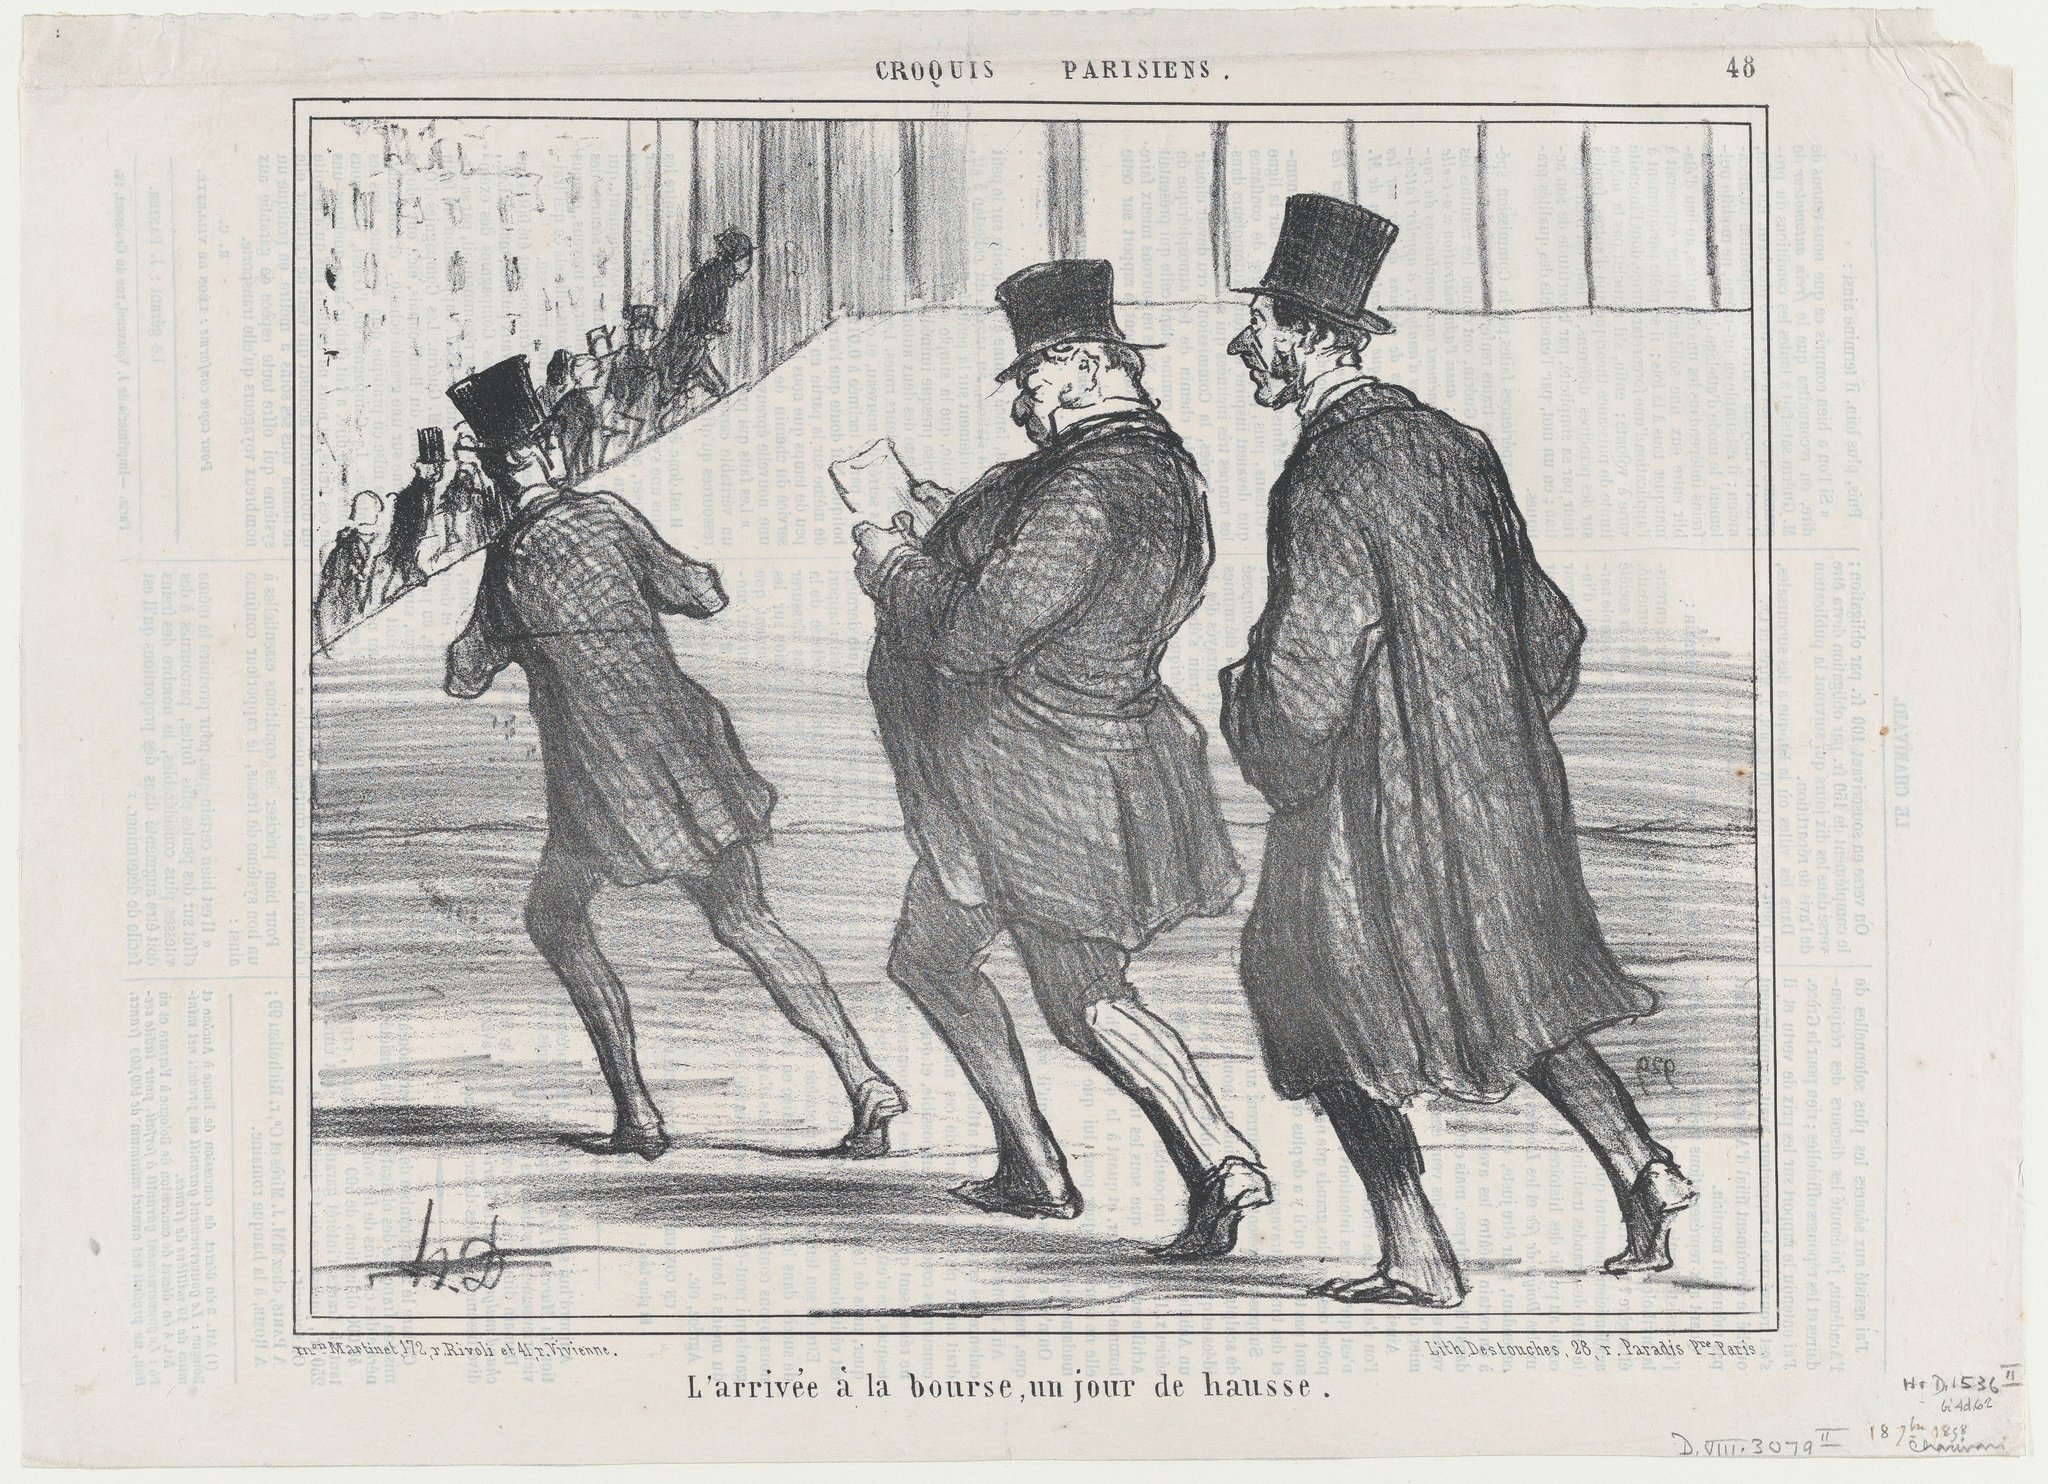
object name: print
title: L'arrivée à la bourse, un jour de hausse, from Croquis Parisiens, published in Le Charivari, September 18, 1858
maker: honoré daumier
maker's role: artist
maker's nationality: french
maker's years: 1808-1879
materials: paper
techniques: lithograph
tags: men,reading,crowd